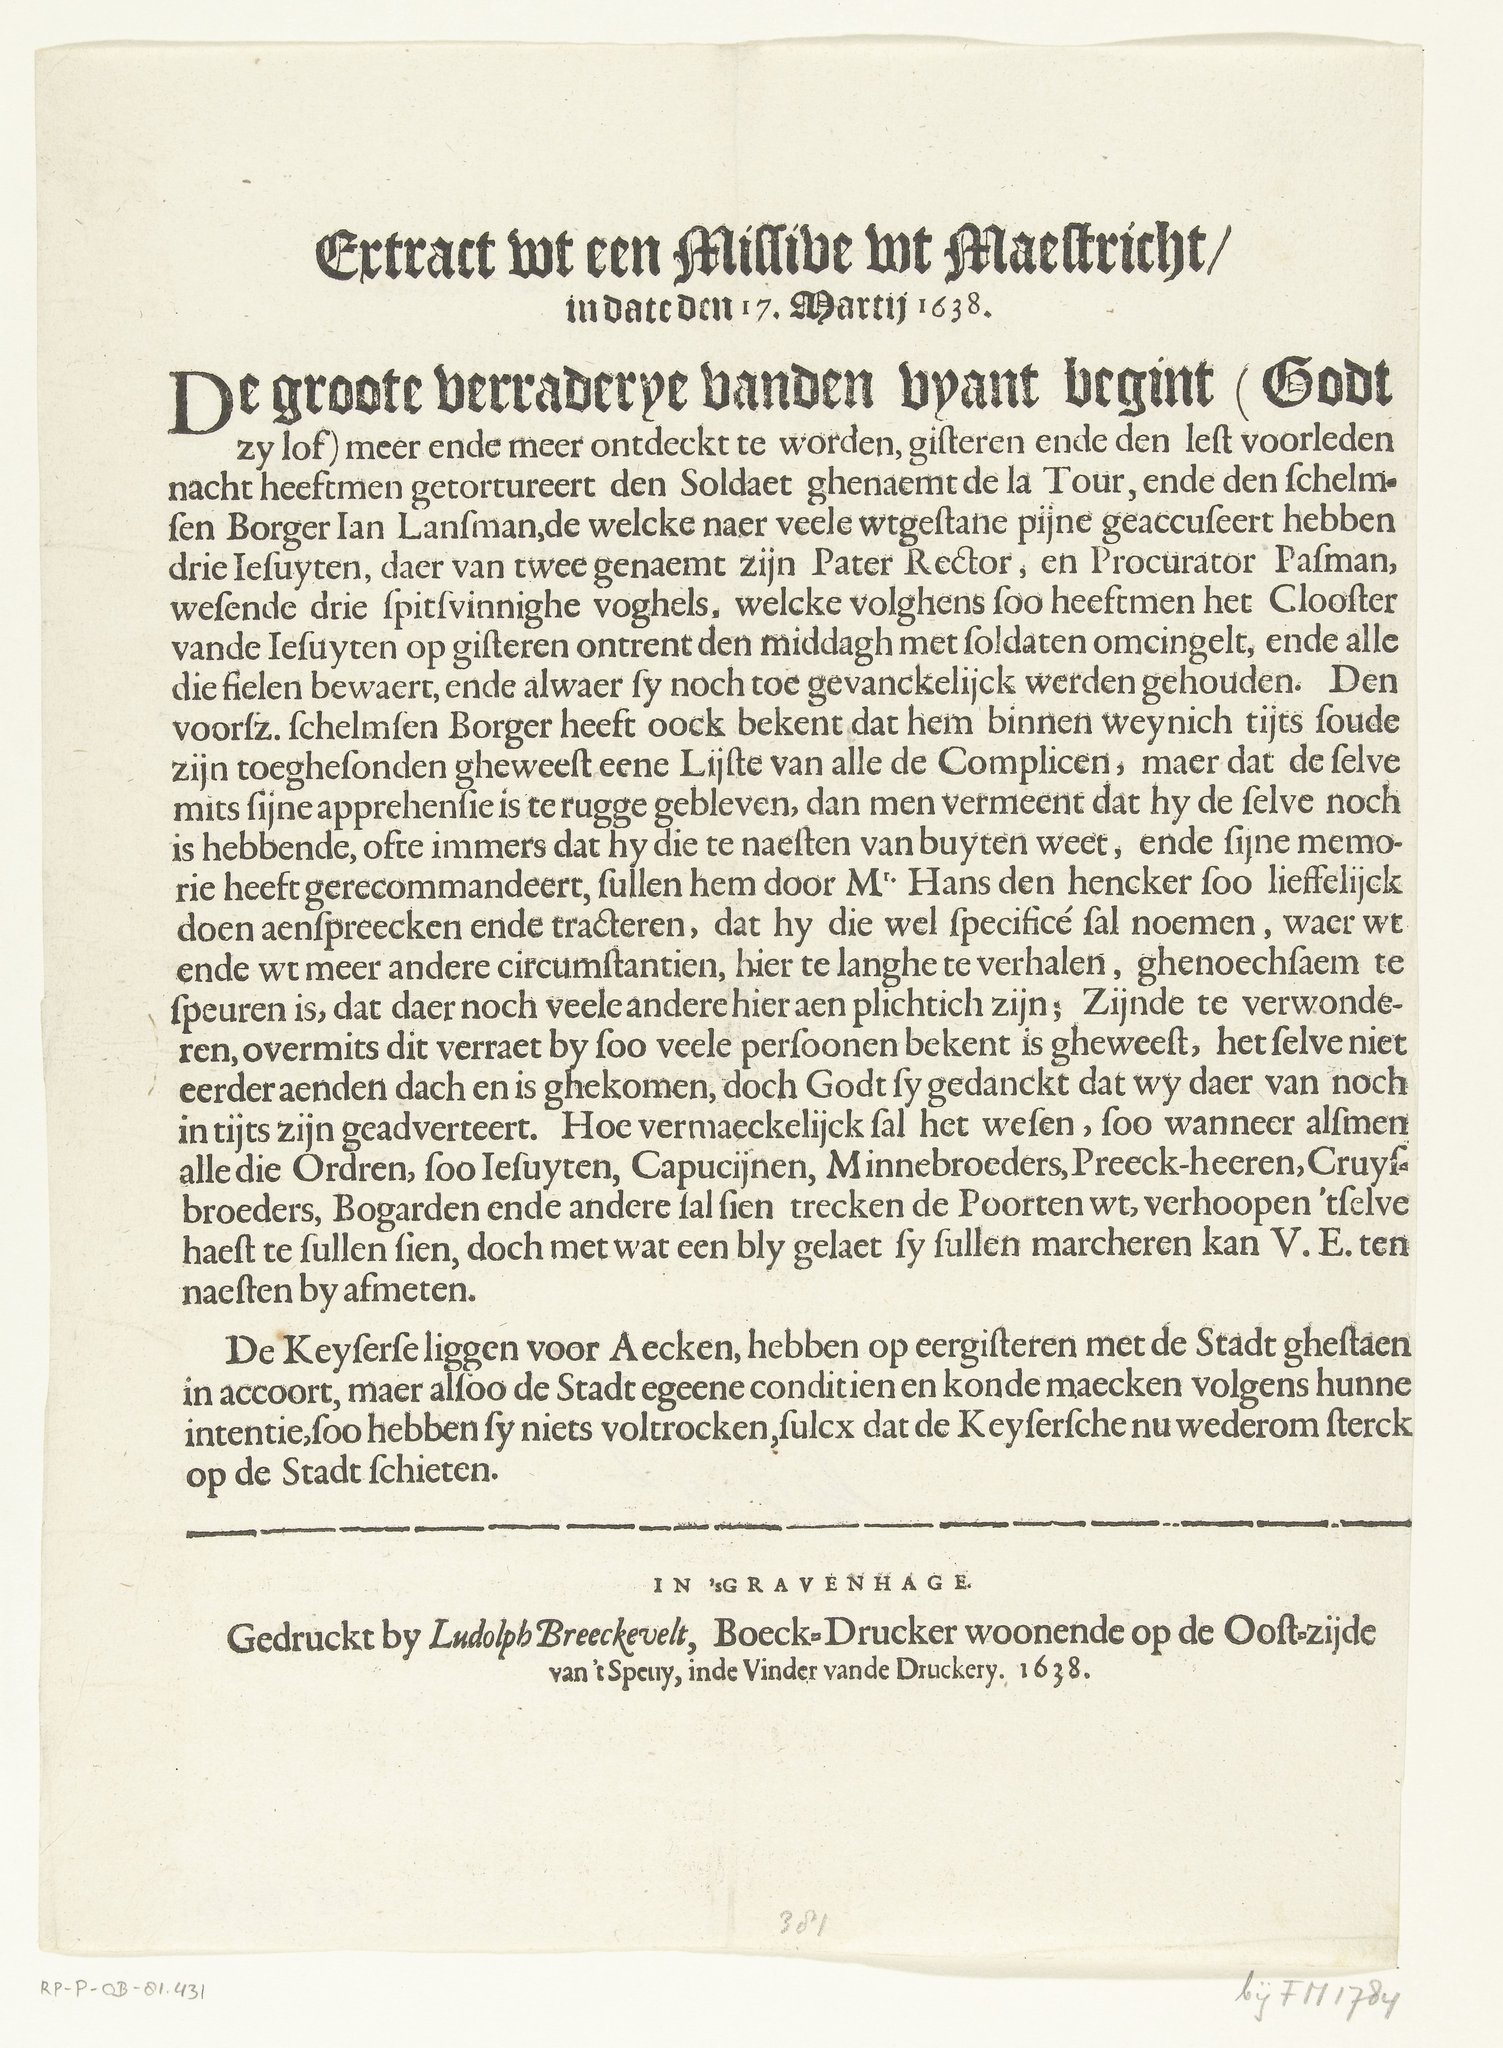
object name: print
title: Extract wt een Missive wt Maestricht / in date den 17. Martij 1638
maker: ludolph breeckevelt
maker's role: publisher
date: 1638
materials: paper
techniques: letterpress printing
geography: the hague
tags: maastricht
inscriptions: date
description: Gedrukt bericht van de ontdekte samenzwering om Maastricht aan de Spanjaarden te verraden, 1638.